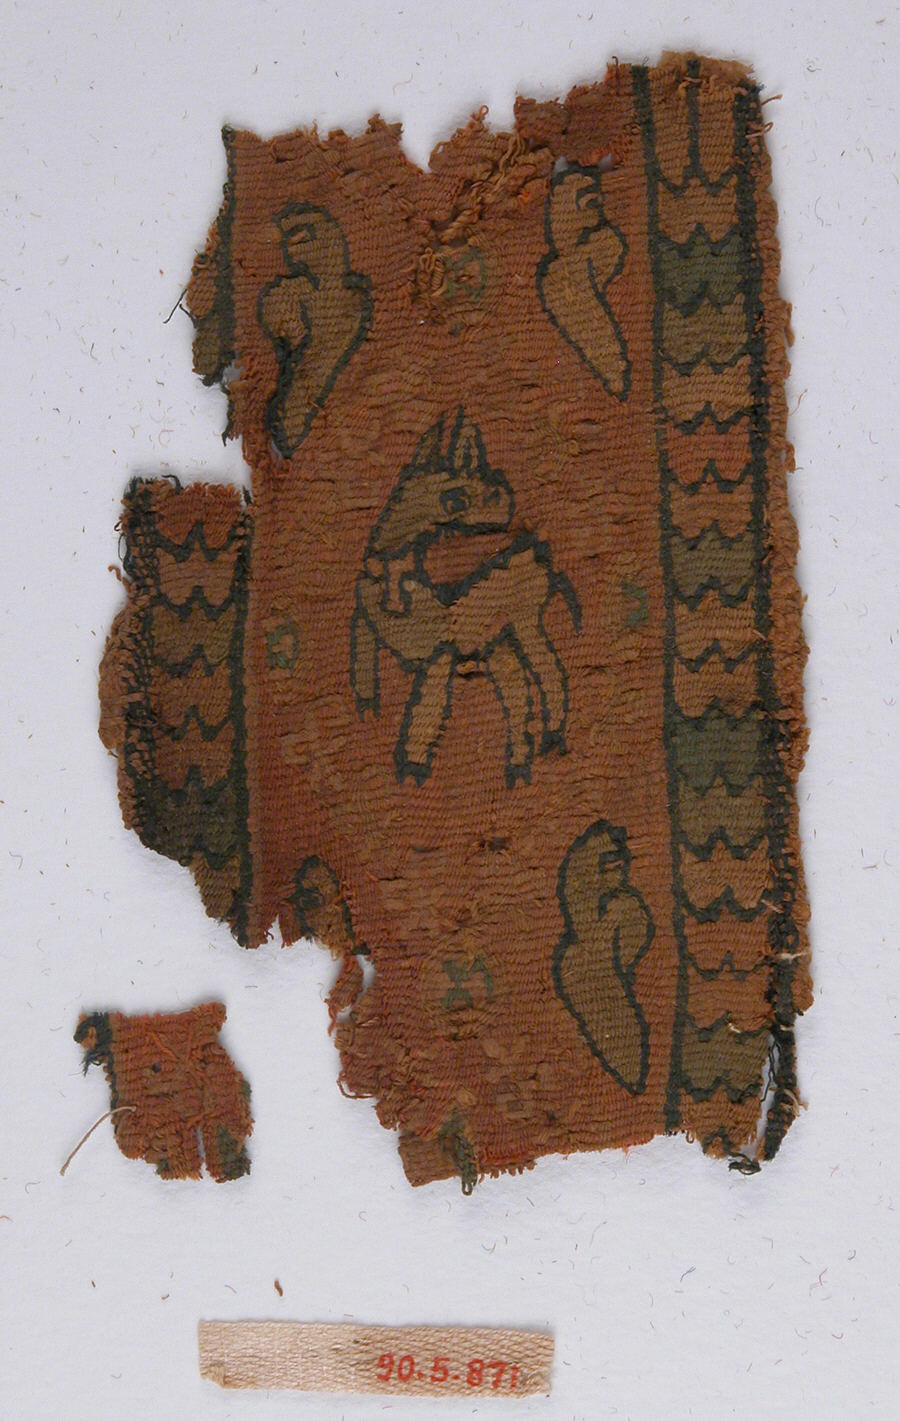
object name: textile fragment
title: Fragment of a Shoulder Band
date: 501-700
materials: linen, wool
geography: egypt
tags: animals